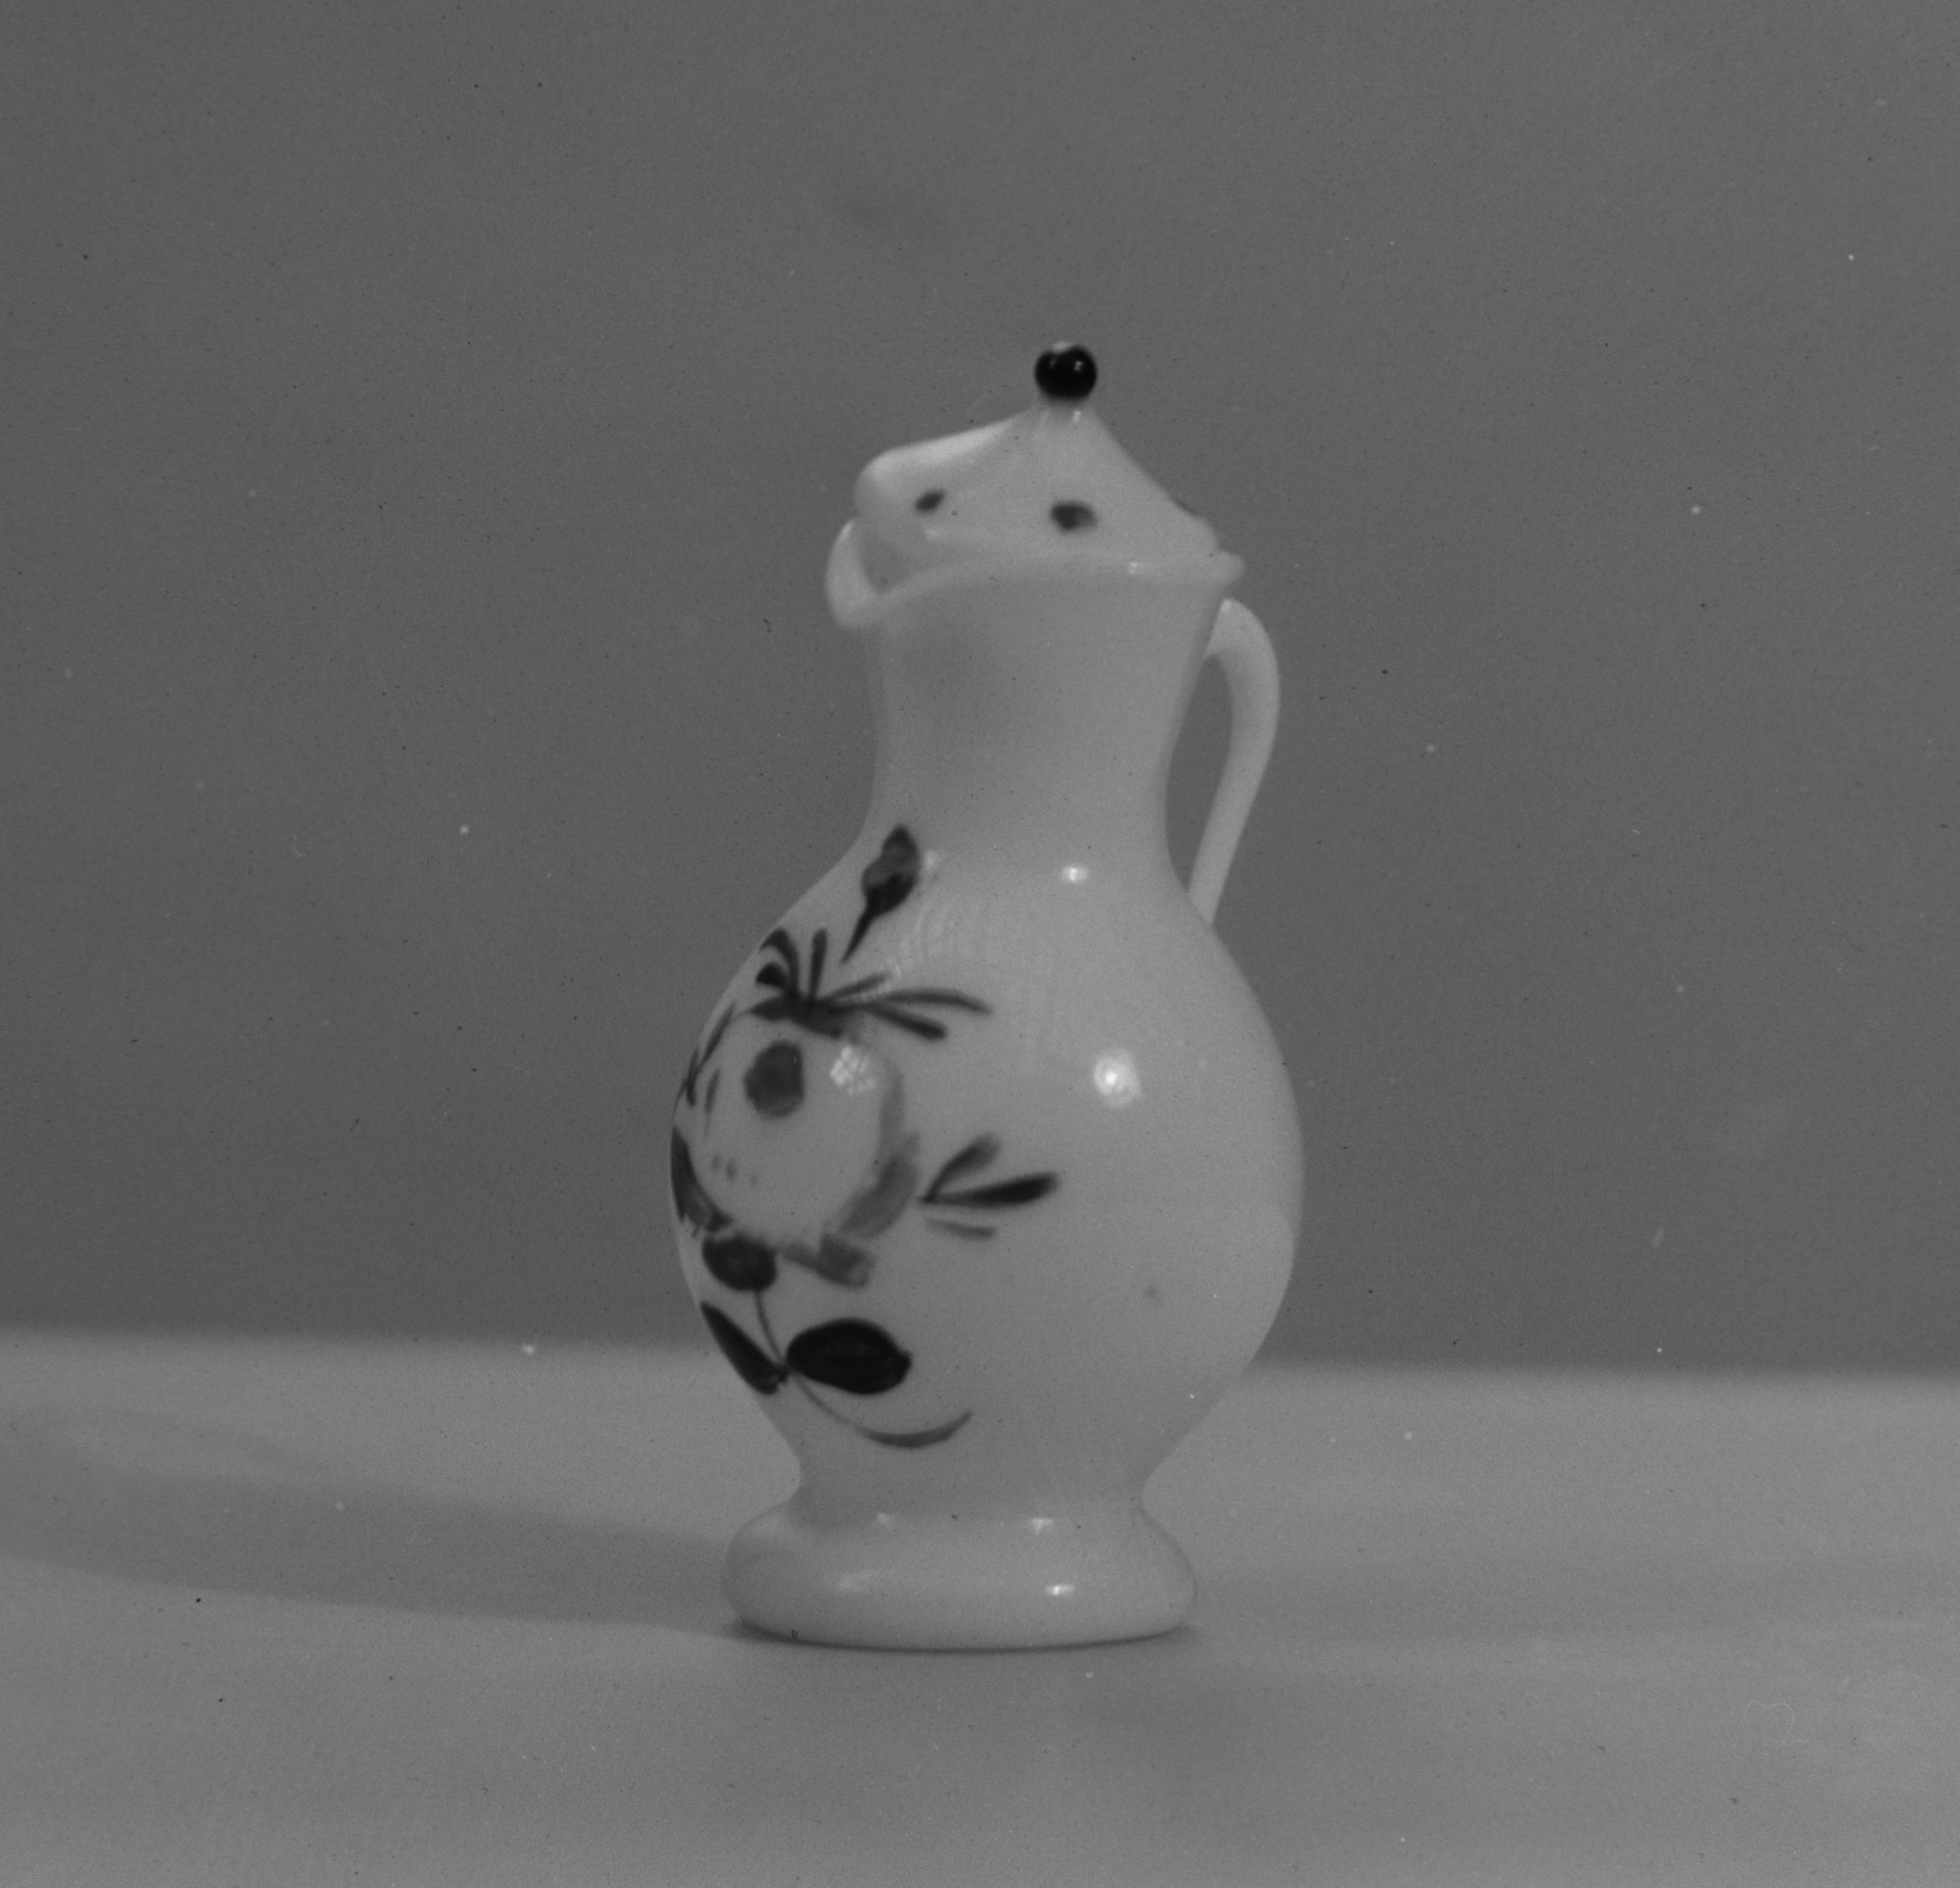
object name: coffeepot with cover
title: Miniature coffeepot with cover (part of a dollhouse set)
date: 1801-1833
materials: glass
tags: flowers